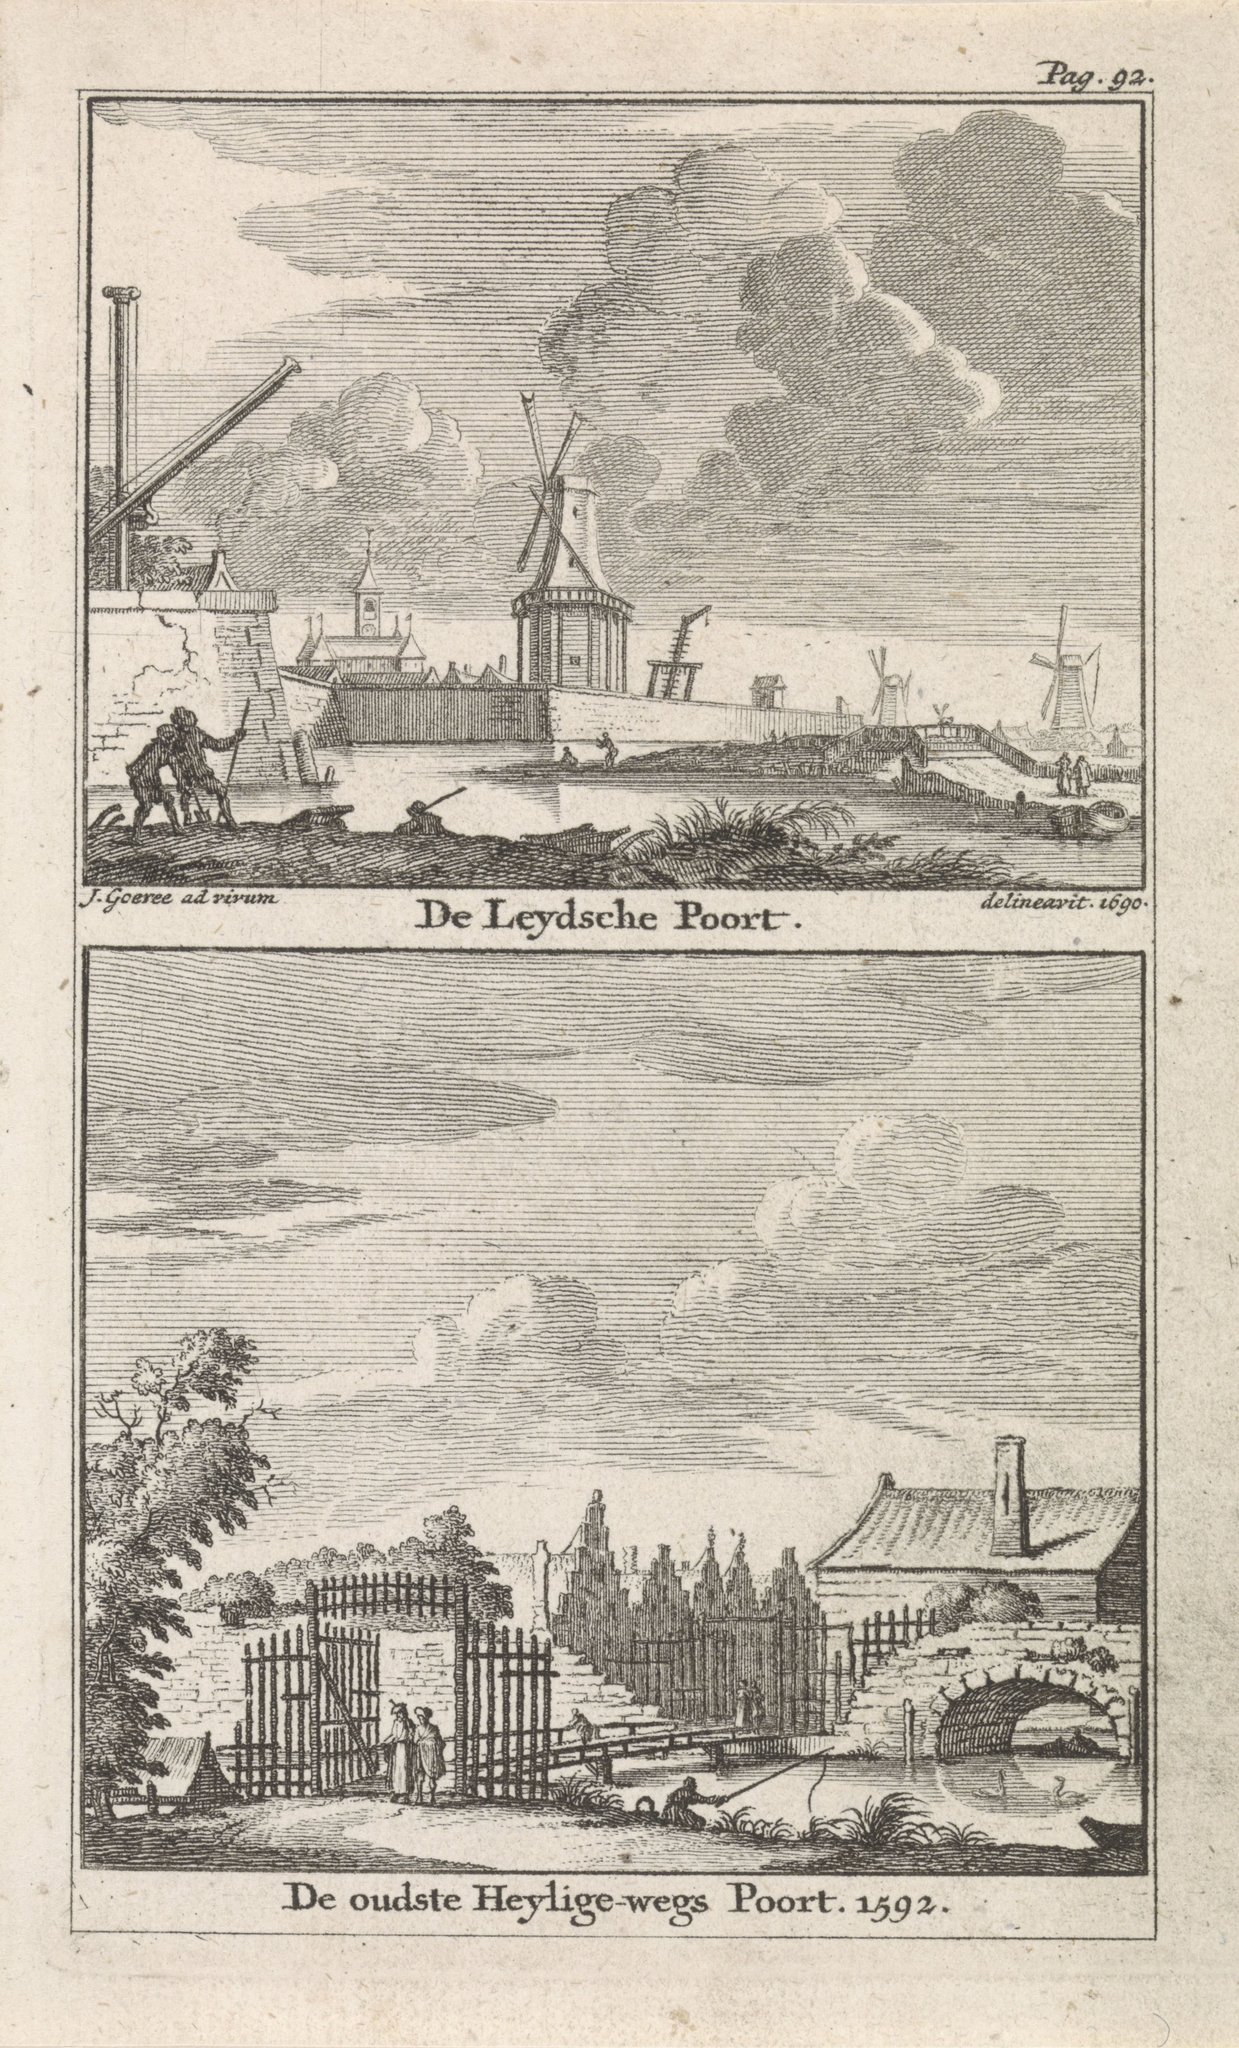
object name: book illustration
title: Gezicht op de Leidsepoort en Heiligewegspoort te Amsterdam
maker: jan goeree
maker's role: draughtsman, print maker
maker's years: 1670-1731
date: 1690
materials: paper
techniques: engraving, etching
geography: amsterdam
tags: city-walls (+ city(-scape) with figures, staffage)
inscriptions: collector's mark: Lugt 2228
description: Twee voorstellingen. Boven: de Leidsepoort van Amsterdam. Onder: de Eerste Heiligewegspoort van Amsterdam rond 1592. Elke voorstelling heeft een Nederlands onderschrift. Rechts bovenaan het paginanummer 92.